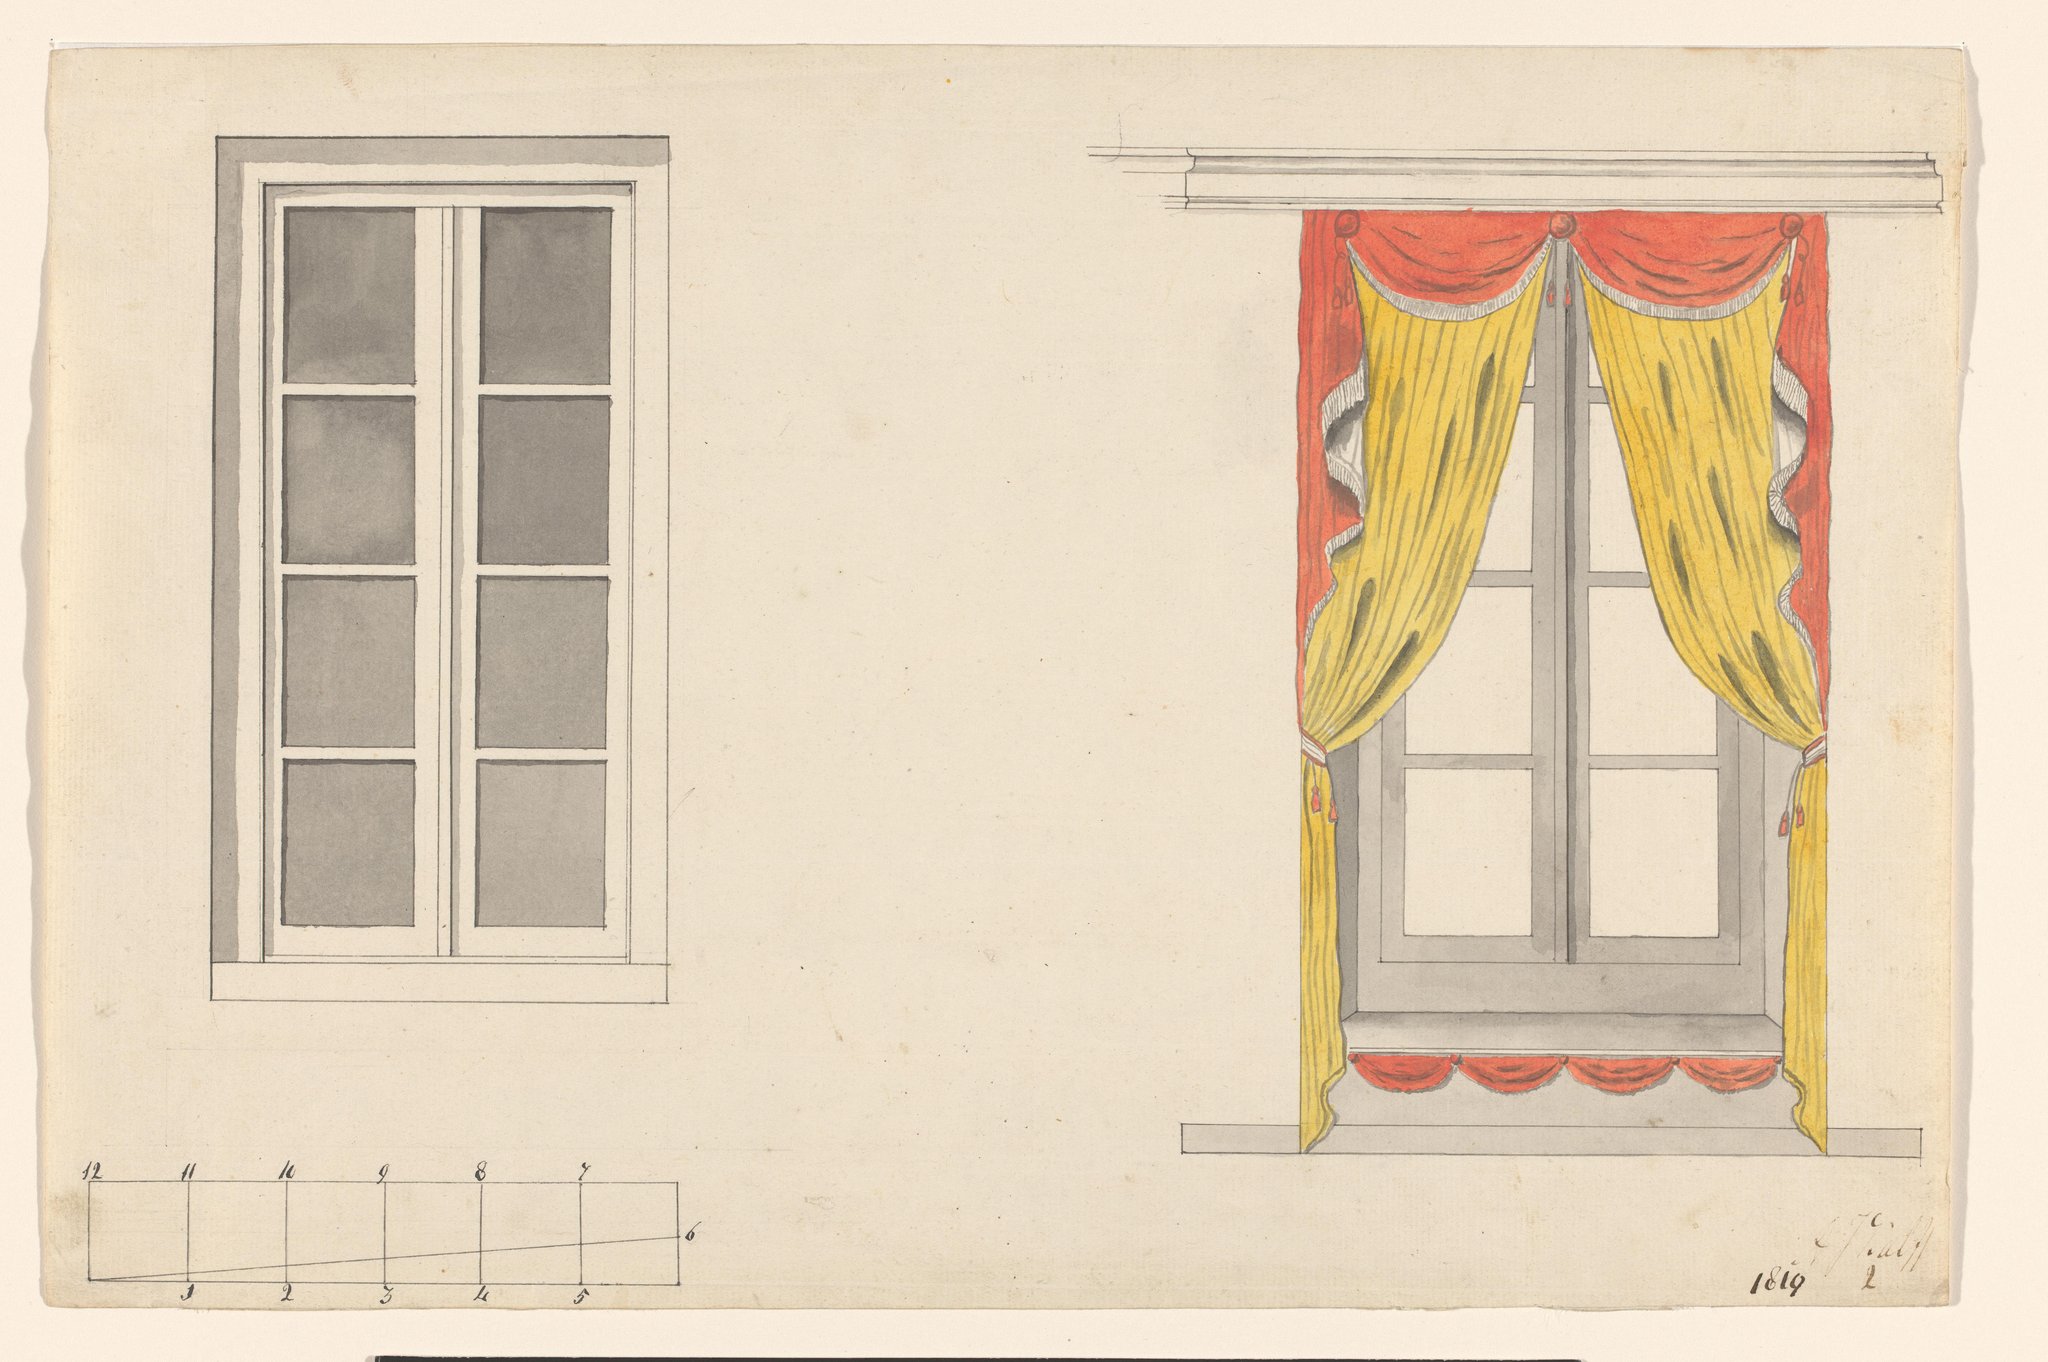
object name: design drawing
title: Een venster van buiten en van binnen, met gedrapeerde dubbele gordijnen en een vensterbank met een draperie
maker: a.j. kalff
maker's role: draughtsman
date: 1819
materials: graphite, ink, paper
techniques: brush, pen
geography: netherlands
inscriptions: inscription, watermark: ‘J HONIG / & / ZOONEN’, signature and date